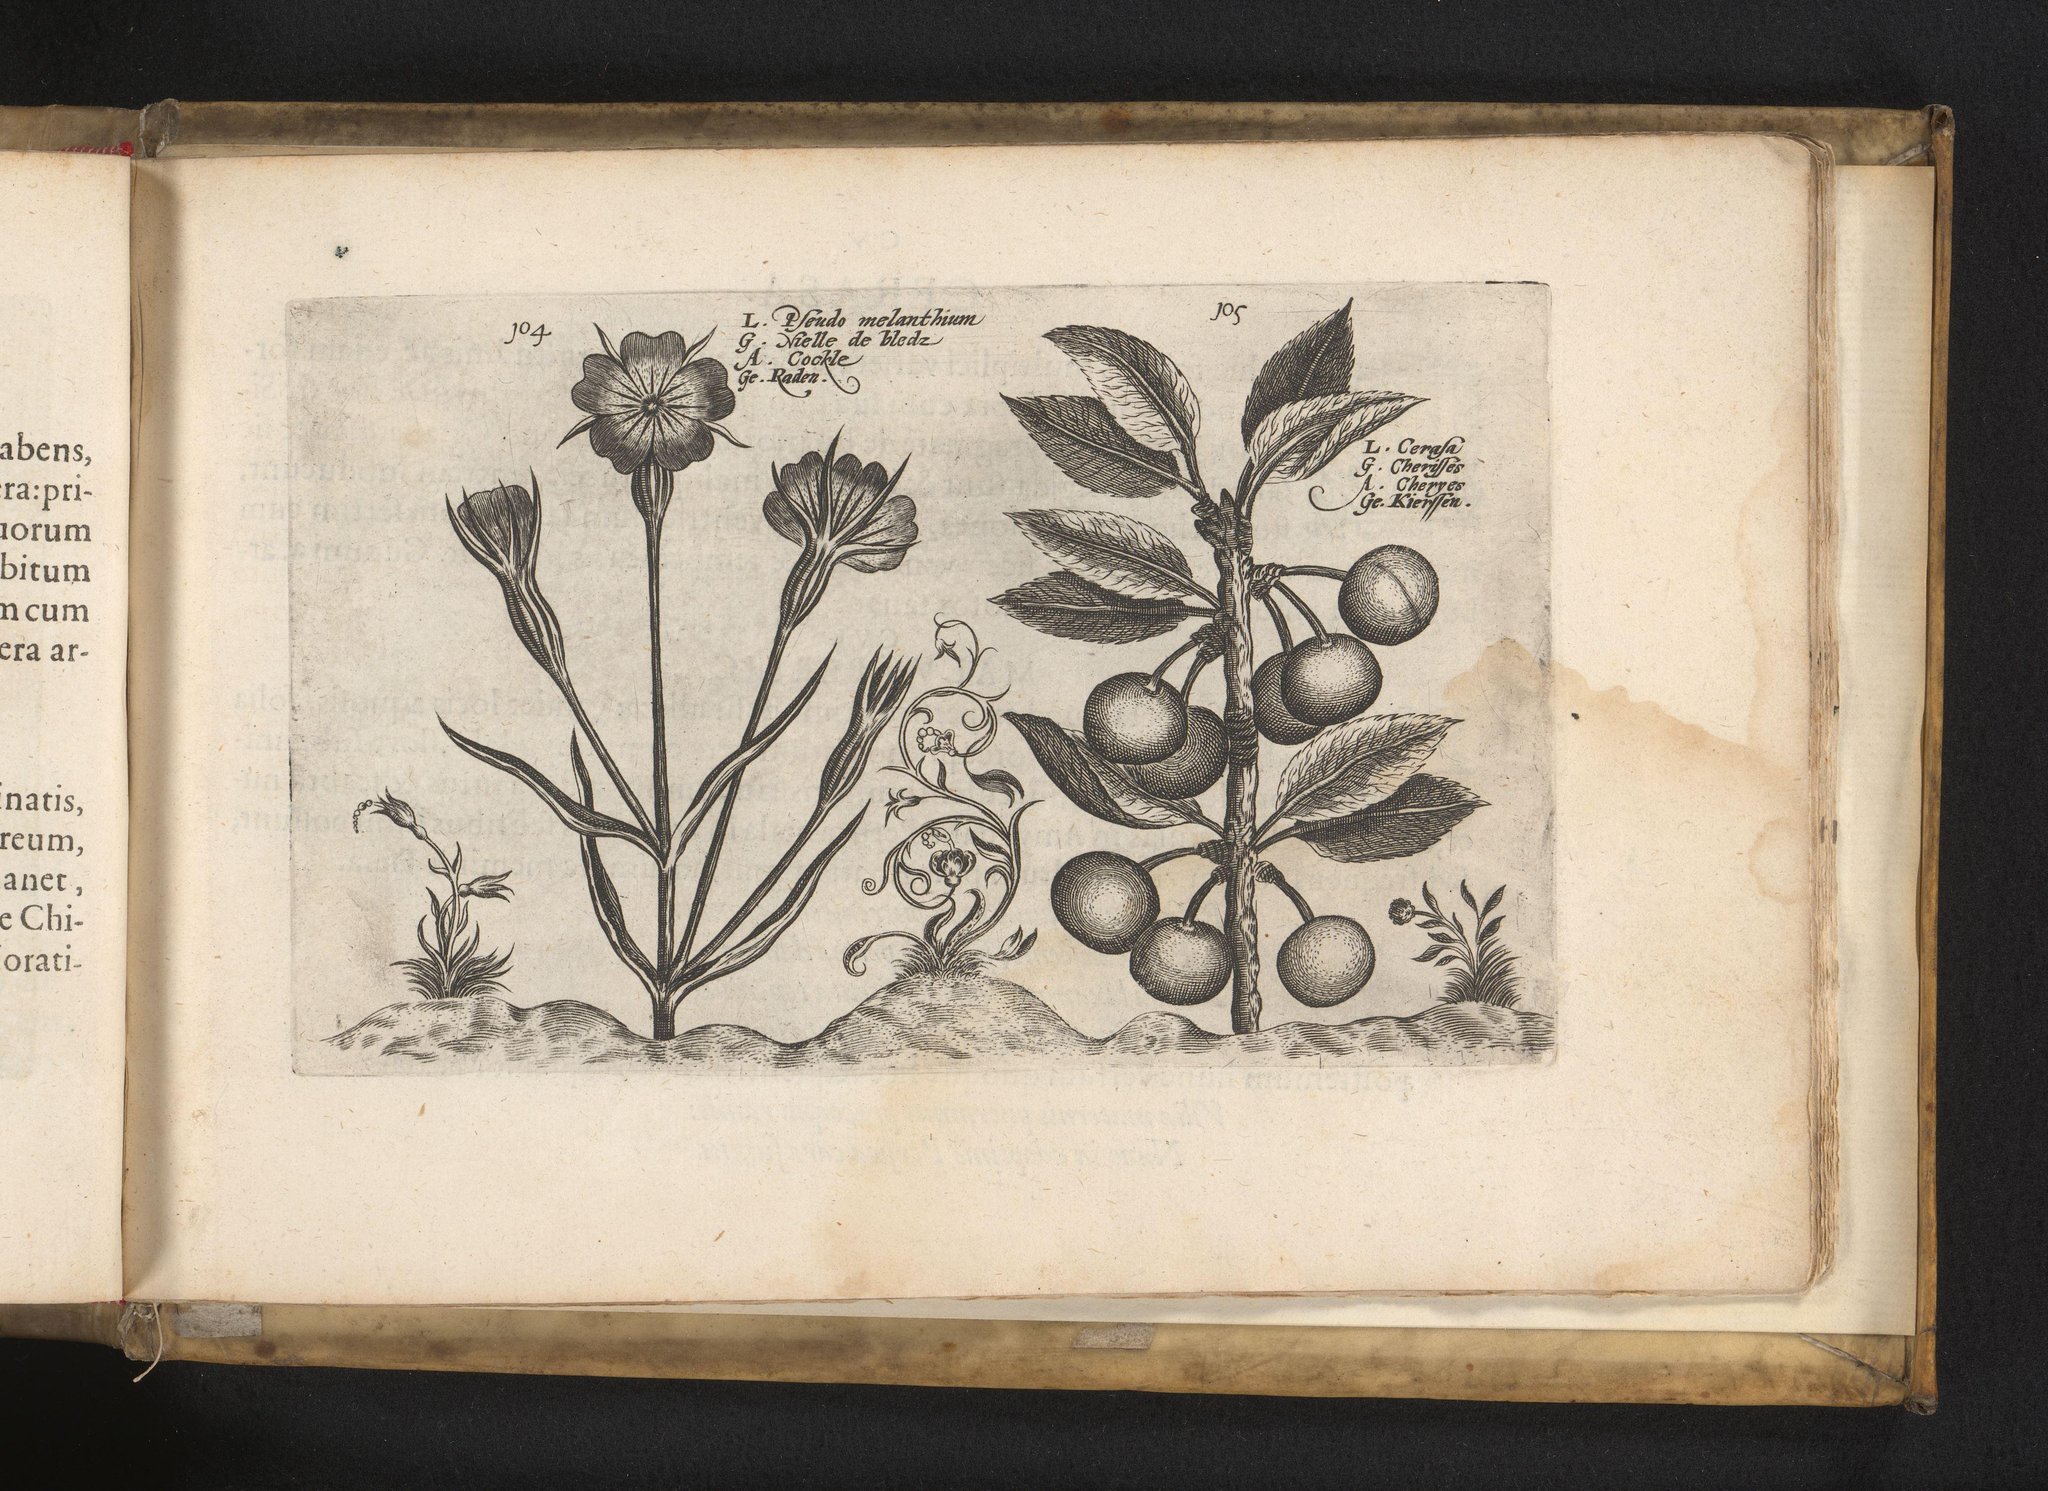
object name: print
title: Pseudo melanthium / Nielle de bledz / Cockle / Raden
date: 1617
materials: paper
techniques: engraving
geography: arnhem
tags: flowers, fruits: cherry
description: Prent uit: Passe, Crispijn van de (II). Hortus floridus in quo rariorum & minus vulgarium florum icones ad vivam veramque formam. Arnhem: Johannes Janssonius, 1617.